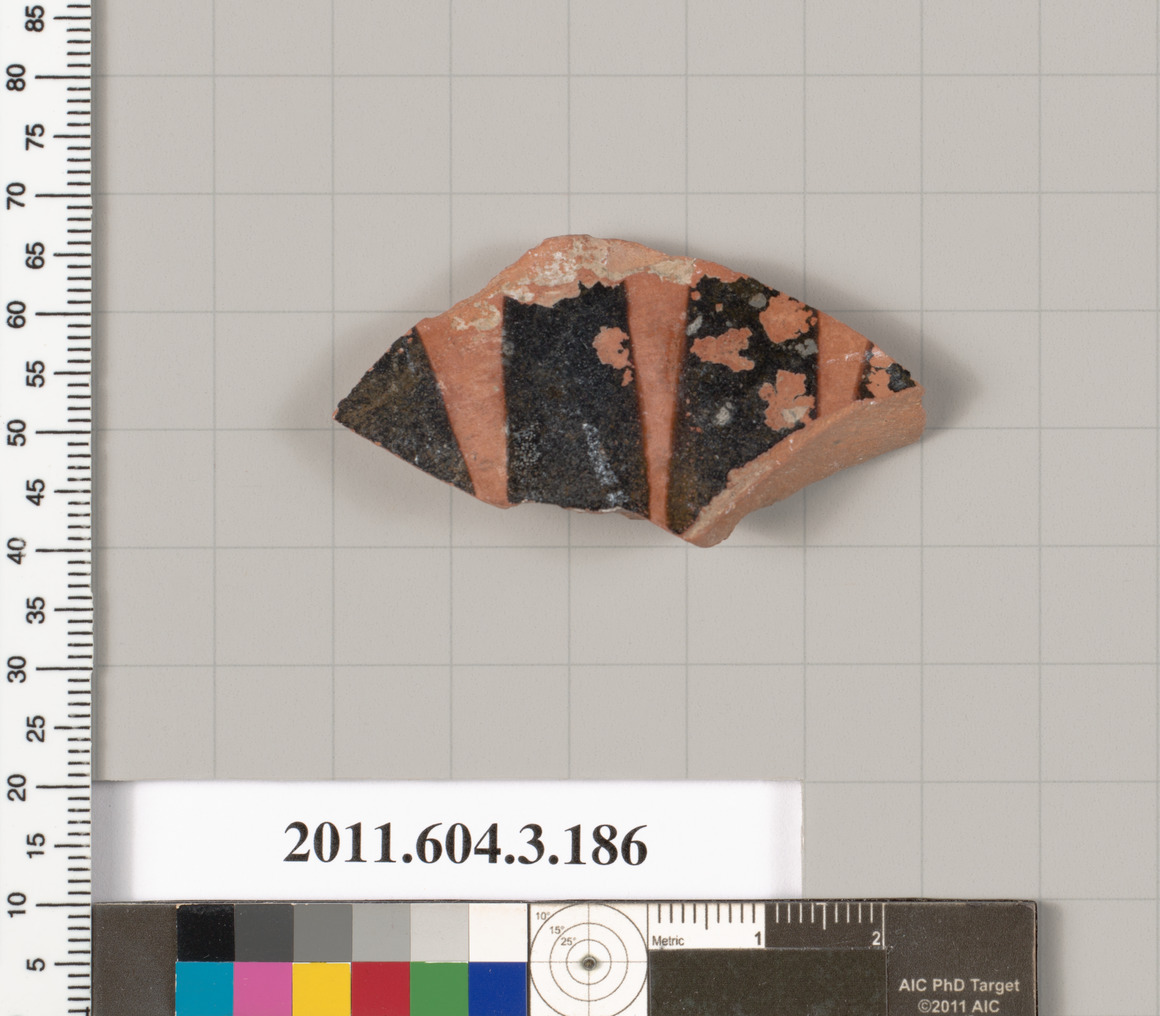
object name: amphora fragment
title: Terracotta fragment of an amphora (jar)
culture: greek, attic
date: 550-501 BCE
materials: terracotta